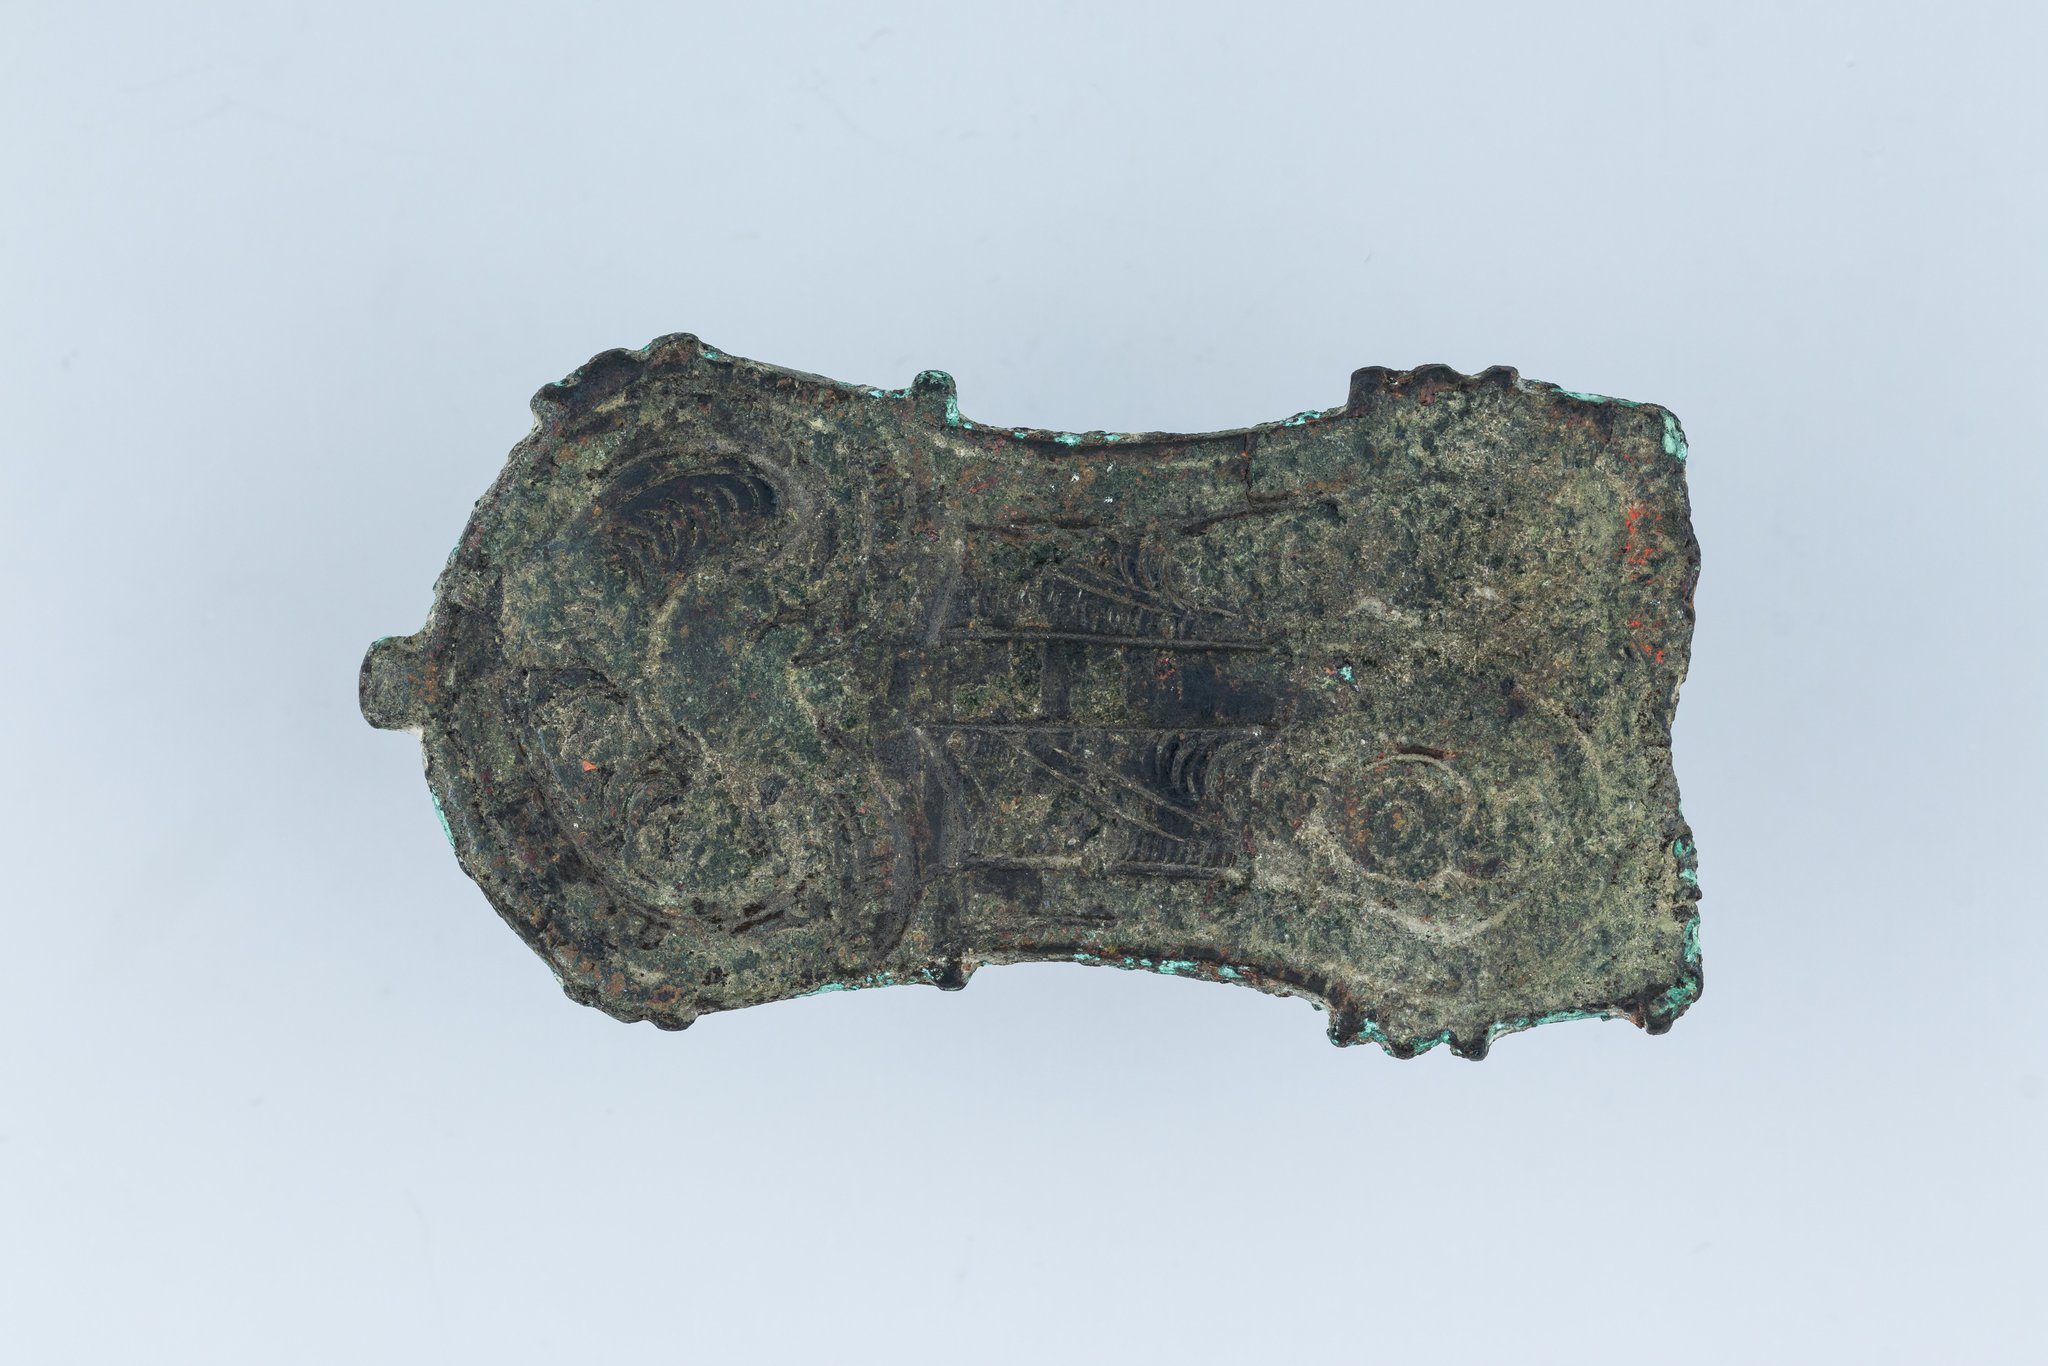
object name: buckle shank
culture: visigothic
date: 401-700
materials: bronze